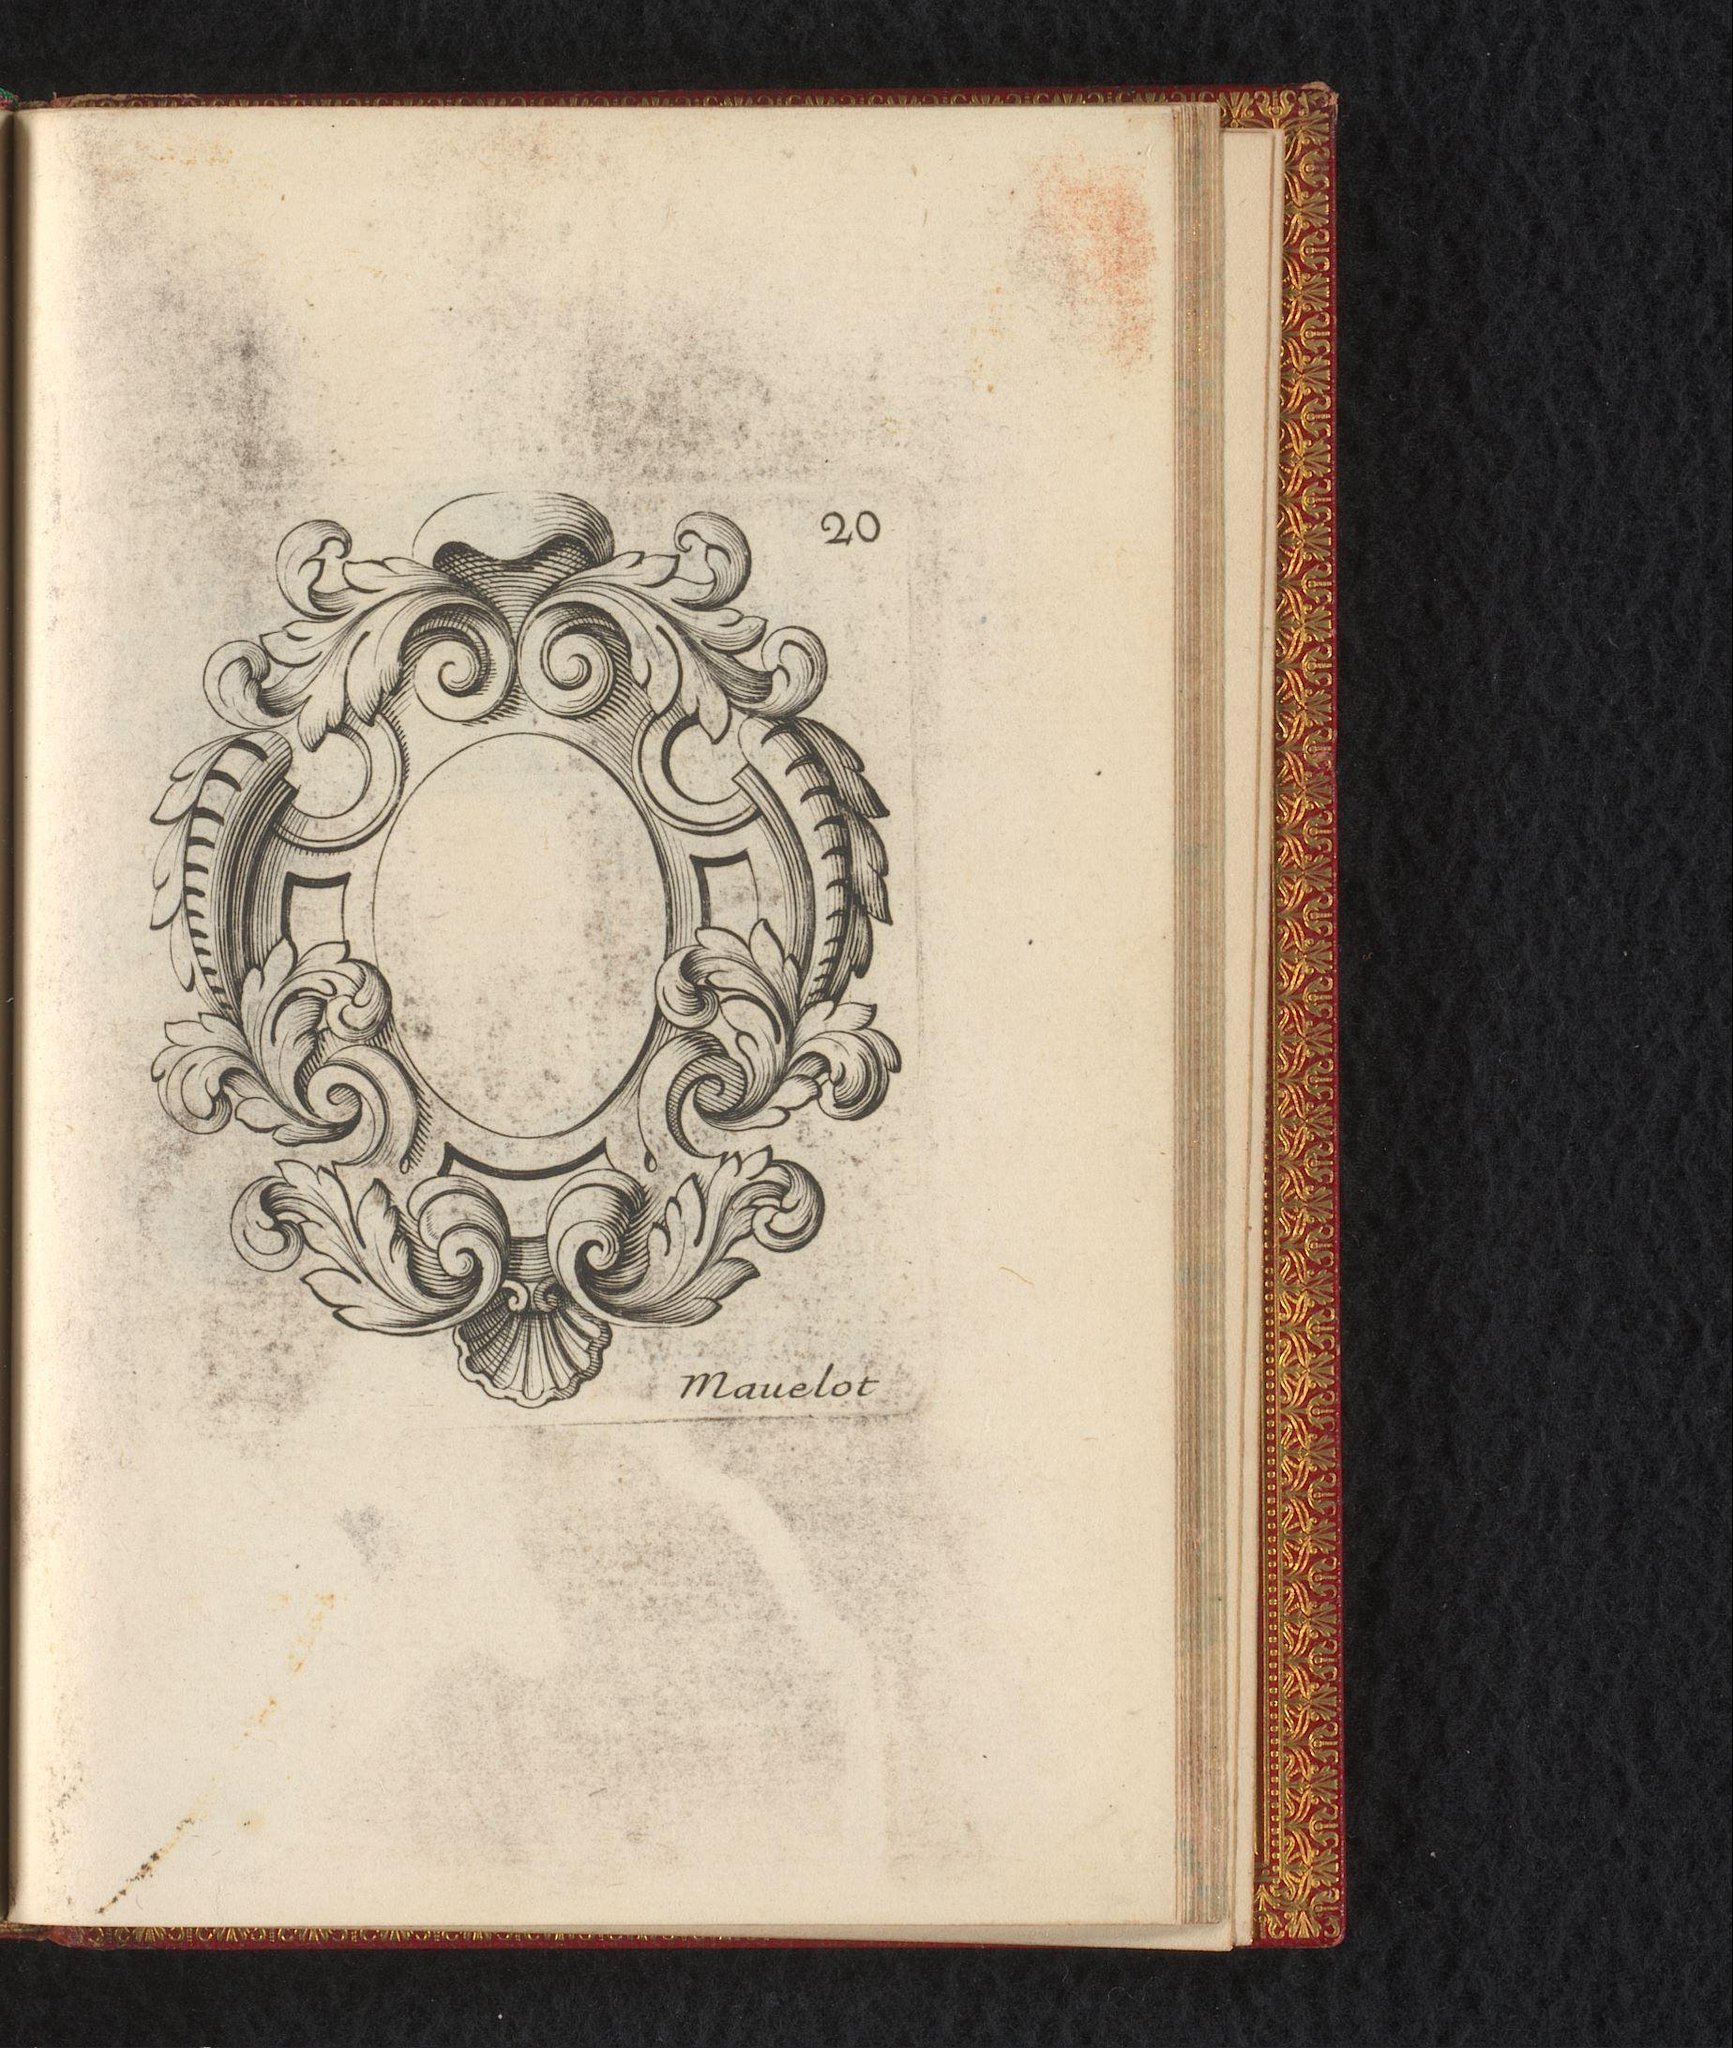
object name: print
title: Cartouche met schelp en acanthusbladeren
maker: charles mavelot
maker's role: draughtsman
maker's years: 1680-1742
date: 1685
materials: paper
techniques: engraving, etching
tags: acanthus ~ ornament, scrollwork, strapwork ~ ornament, scallop, shell ~ ornament, ornament ~ cartouche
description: Rechtsboven genummerd: 20. Prent maakt deel uit van een album.